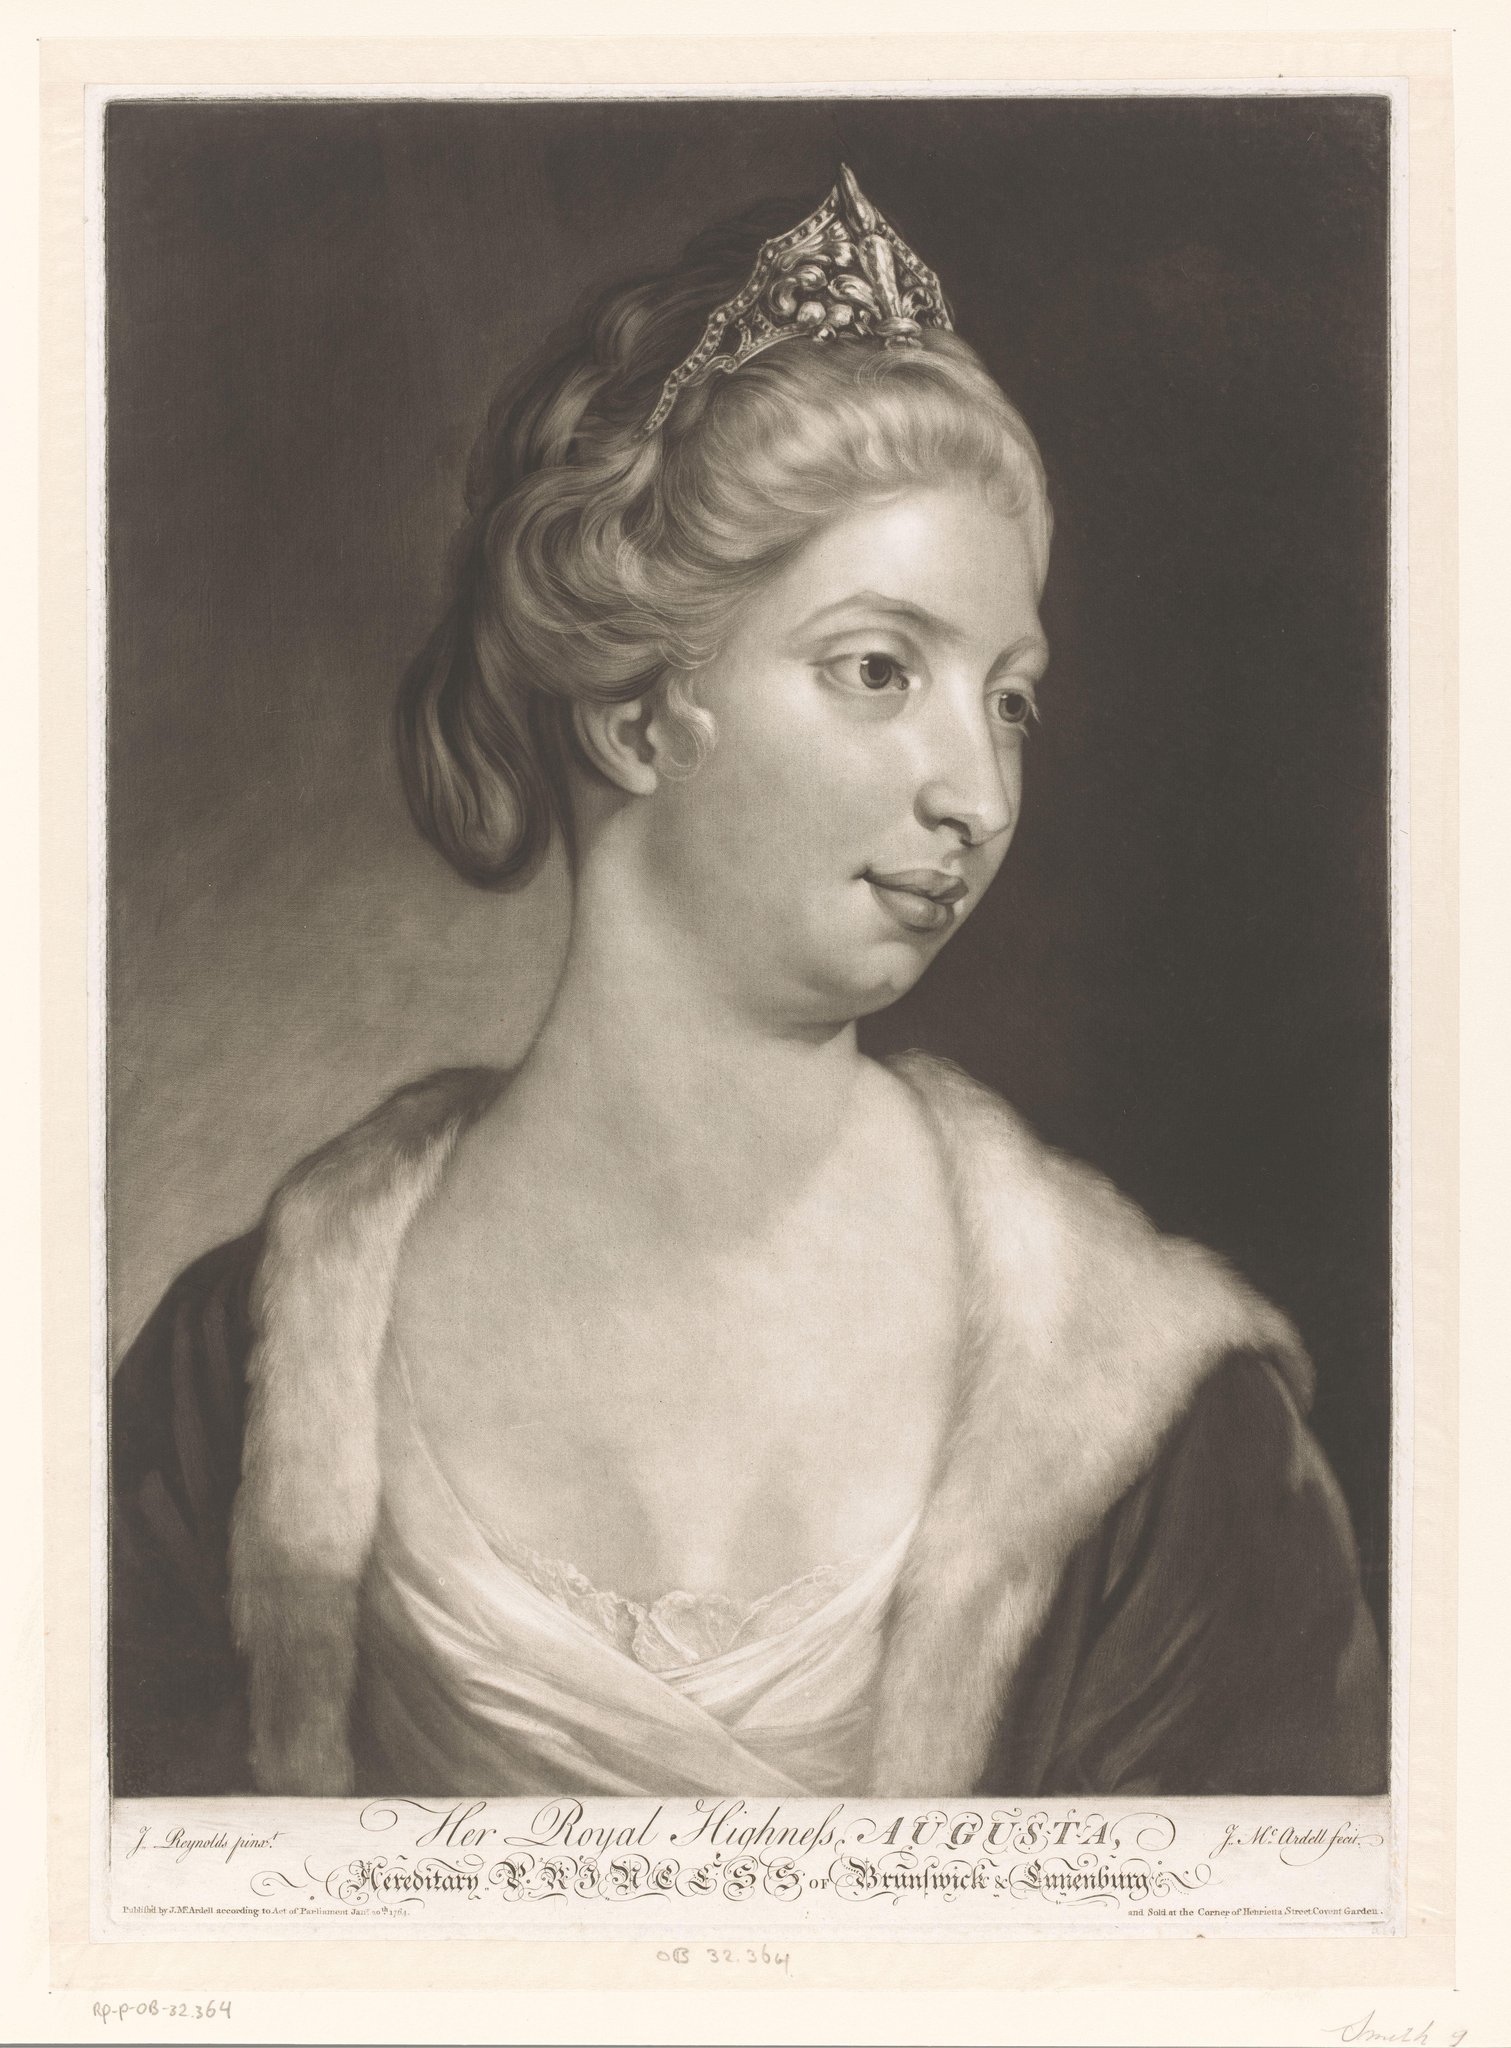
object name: print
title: Portret van Augusta Frederika van Hannover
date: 1701-1764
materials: paper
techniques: mezzotint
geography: london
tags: london, politician, historical persons - bb - woman, princess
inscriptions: date